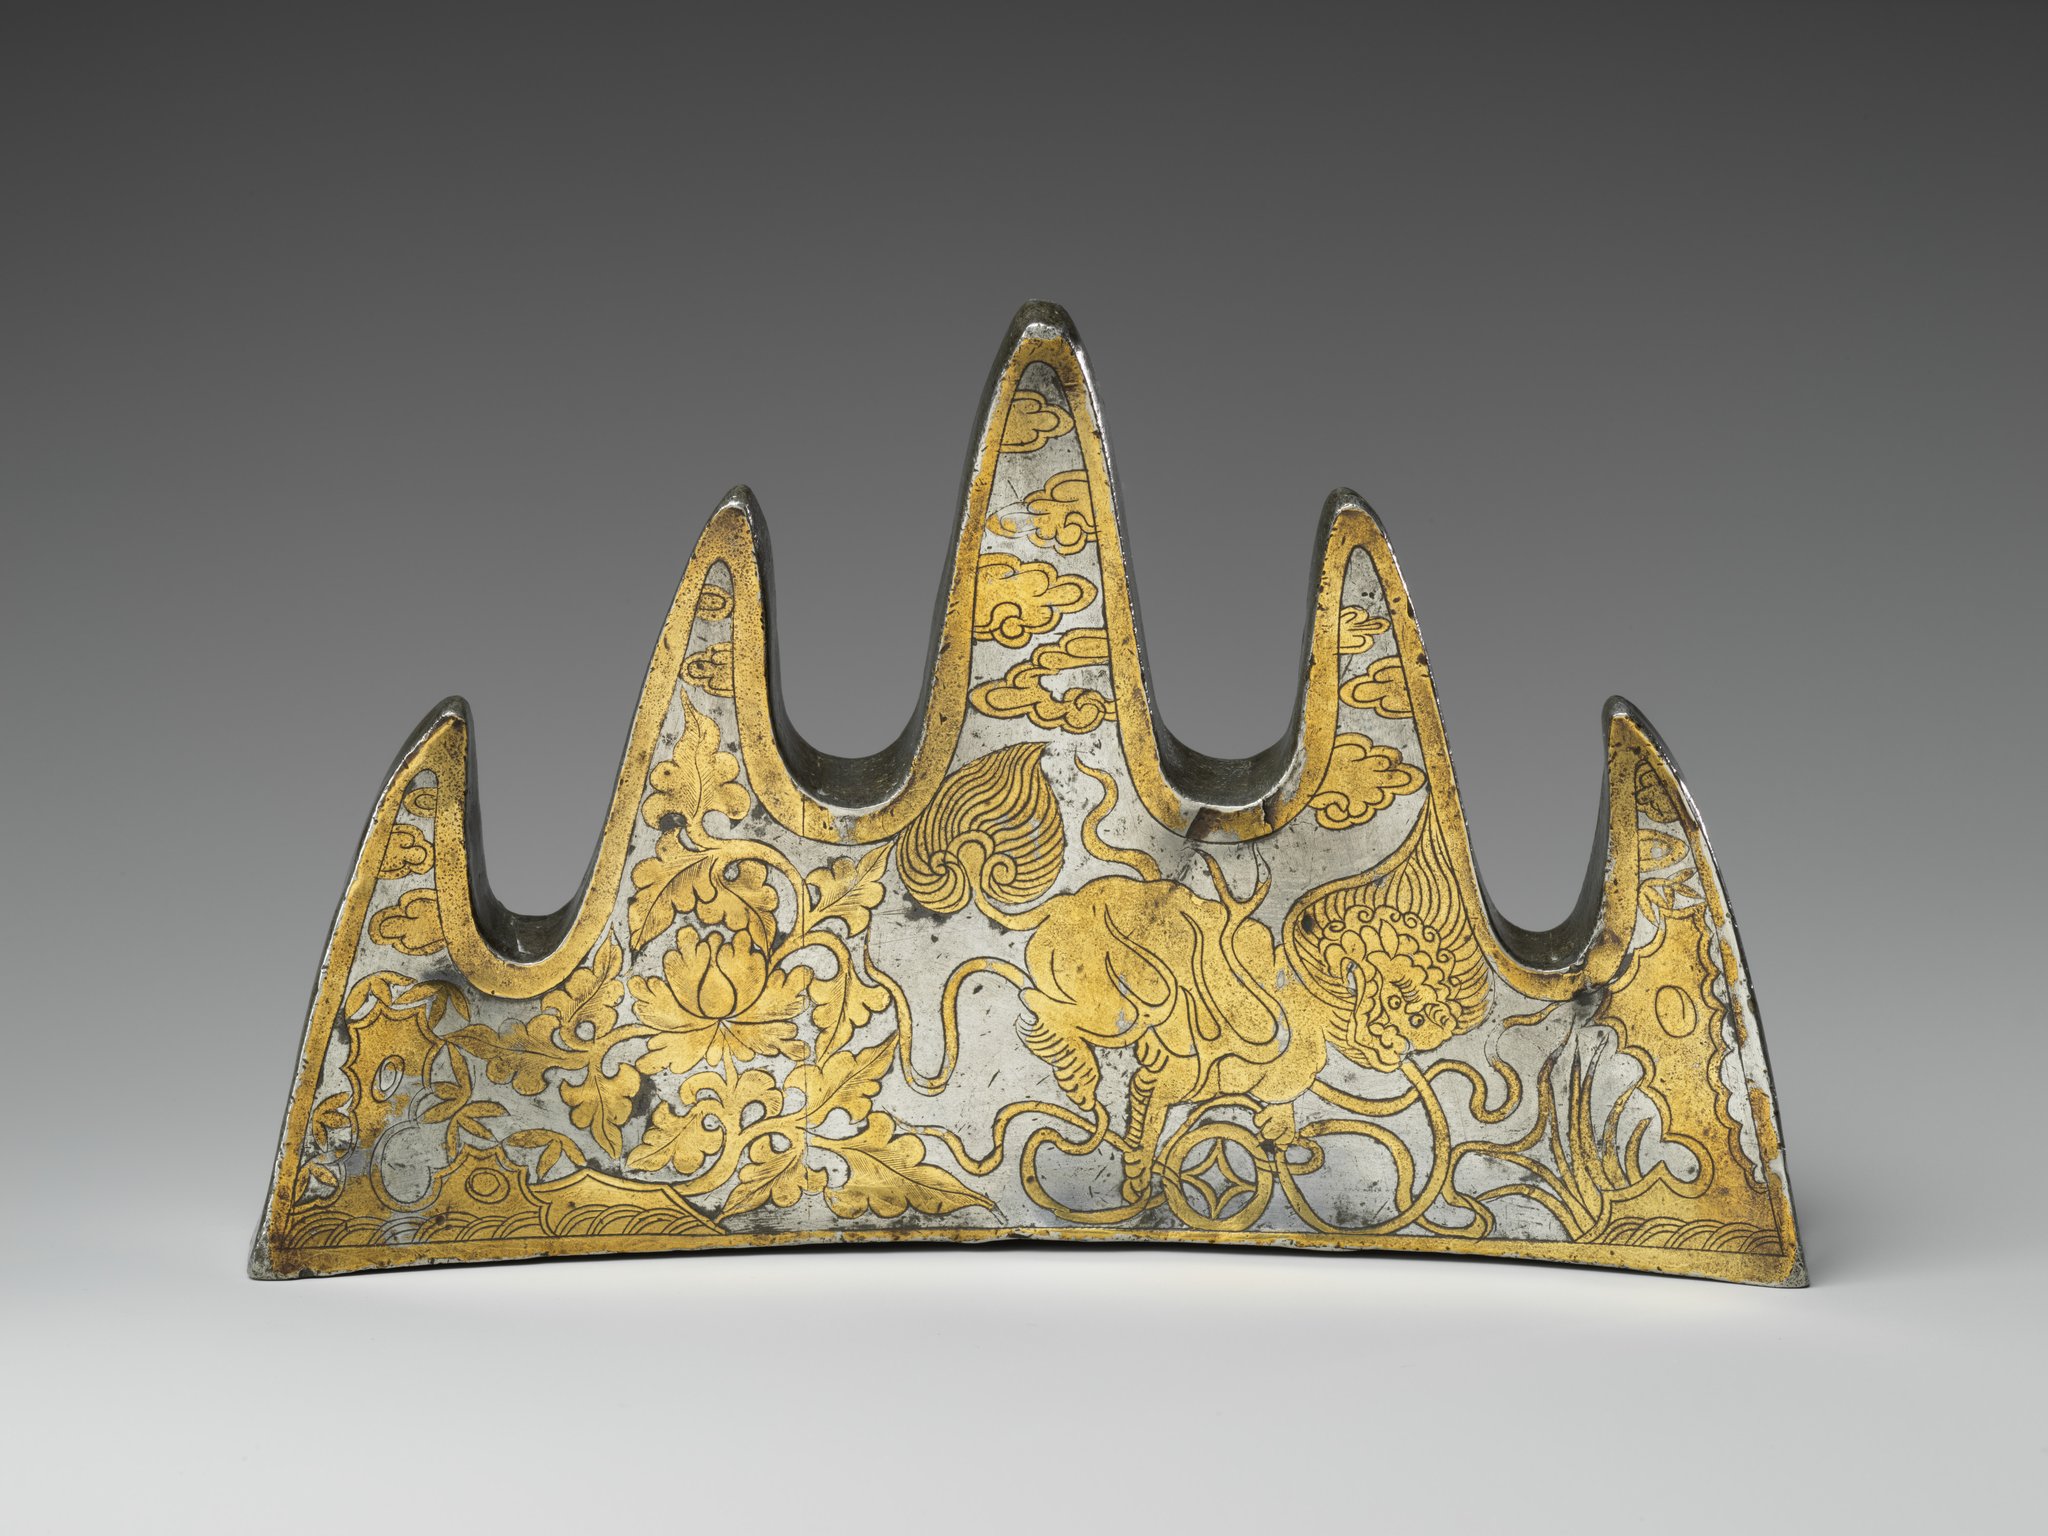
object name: brush rest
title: Mountain-form brush rest with mythical beasts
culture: chinese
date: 1601-1700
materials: brass, pewter